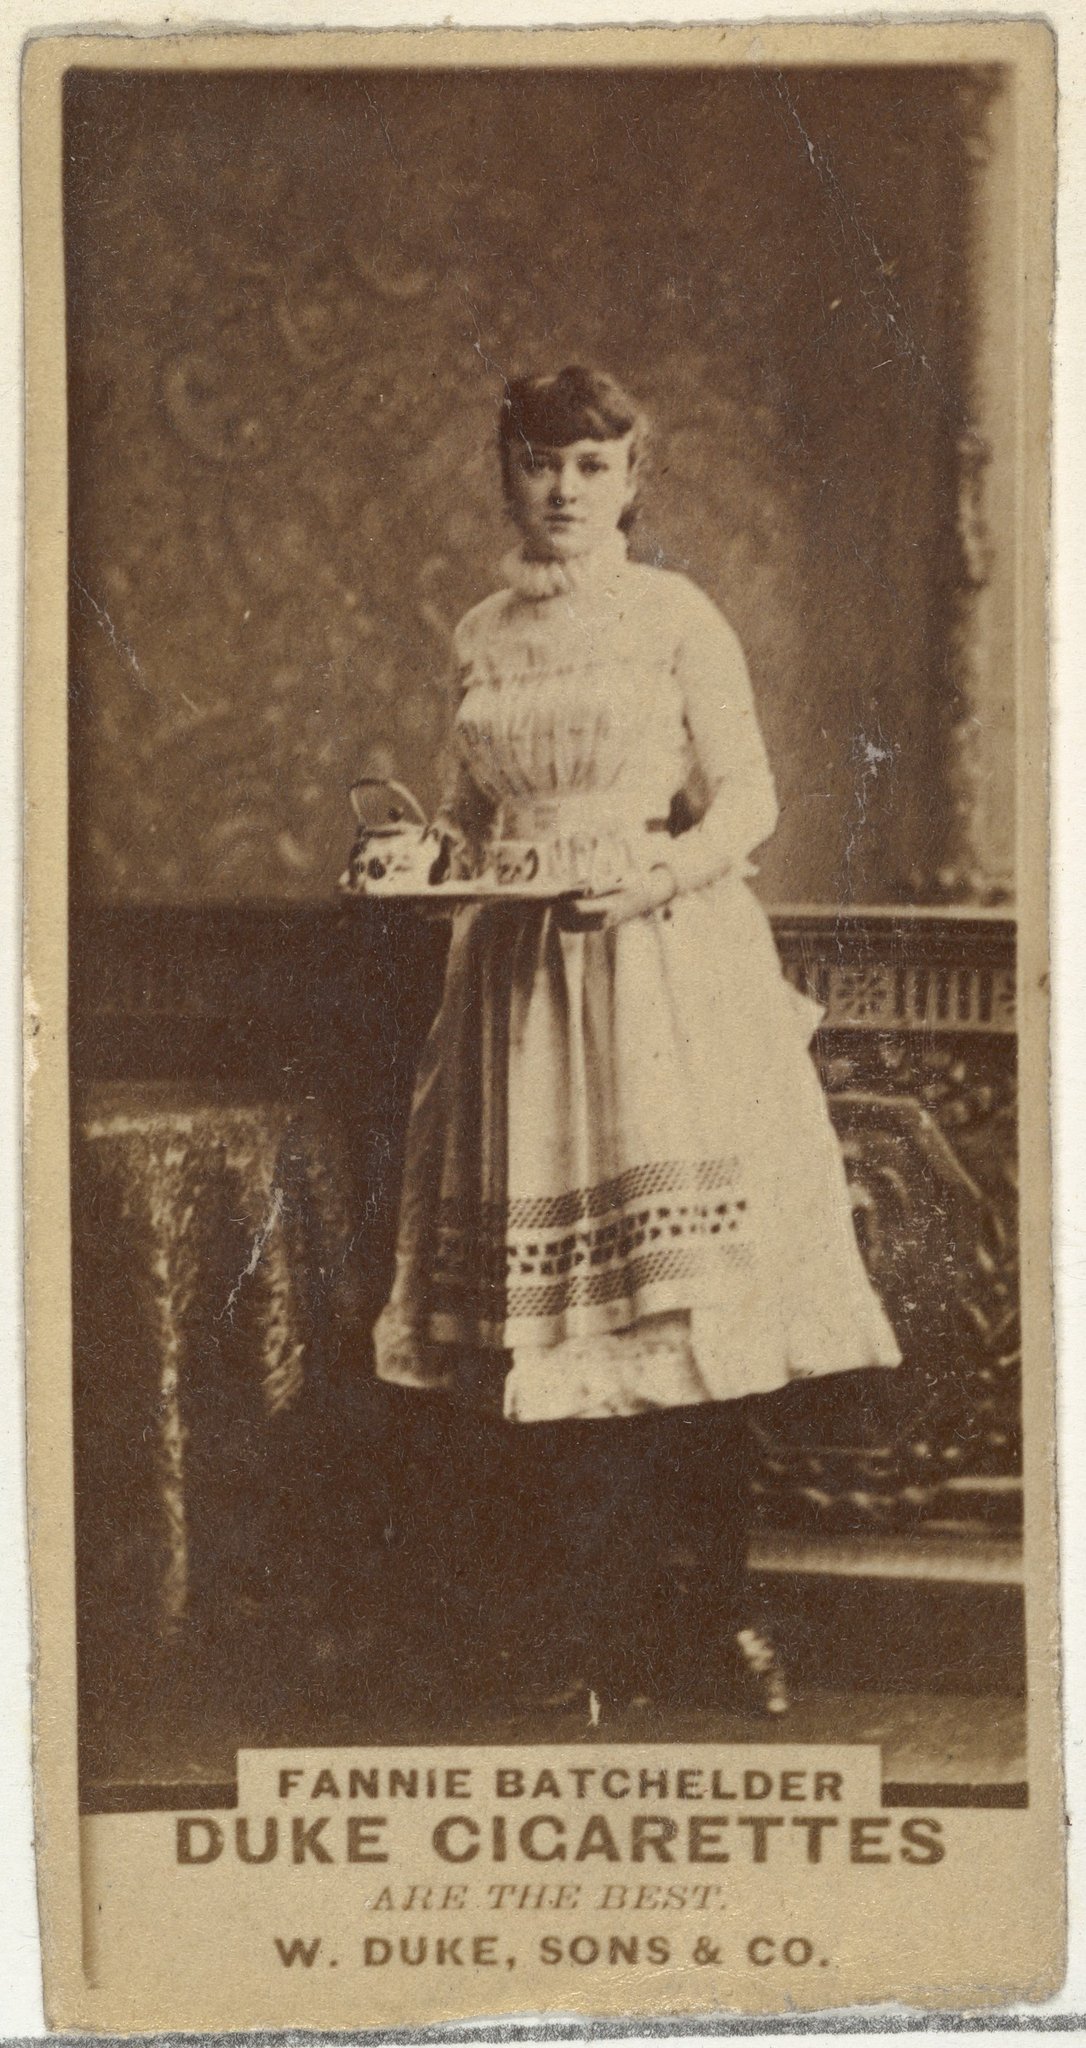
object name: photograph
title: Fannie Batchelder, from the Actors and Actresses series (N145-7) issued by Duke Sons & Co. to promote Duke Cigarettes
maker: w. duke, sons & co.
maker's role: publisher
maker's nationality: american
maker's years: 1870-1920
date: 1880-1889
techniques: albumen silver print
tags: portraits,women,actresses